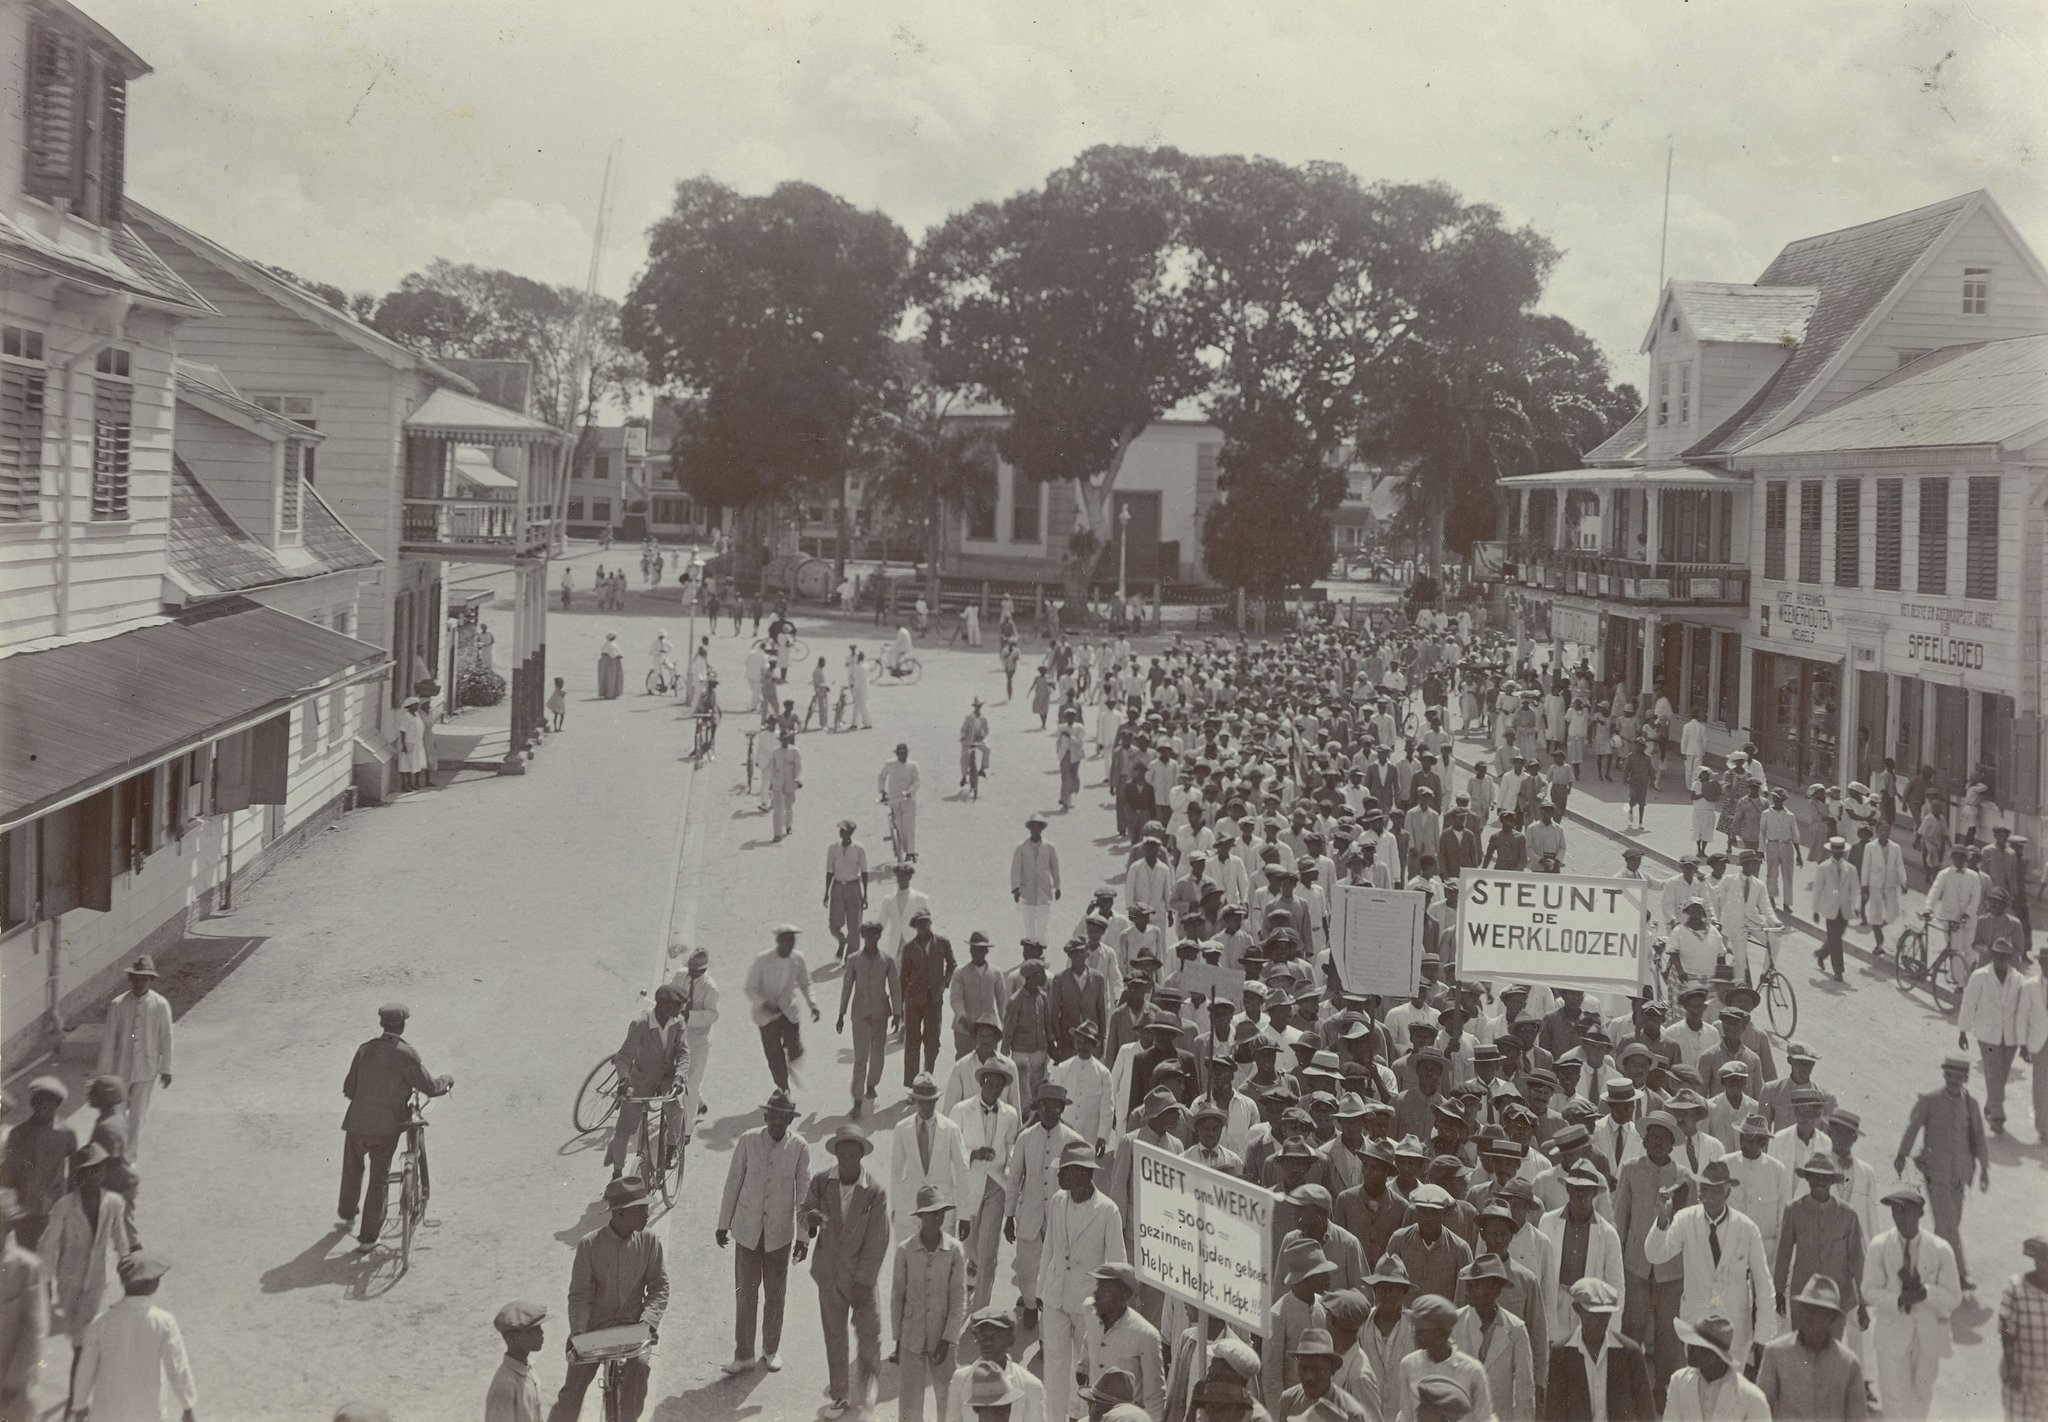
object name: photograph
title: Werklozendemonstratie in Paramaribo in 1931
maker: augusta curiel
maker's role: fotograaf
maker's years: 1873-1937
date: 1931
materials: photographic support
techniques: photography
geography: paramaribo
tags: 46a1791 unemployed labourers, strike (political demonstration)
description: Werklozendemonstratie in Paramaribo in 1931 naar aanleiding van de economische crisis.